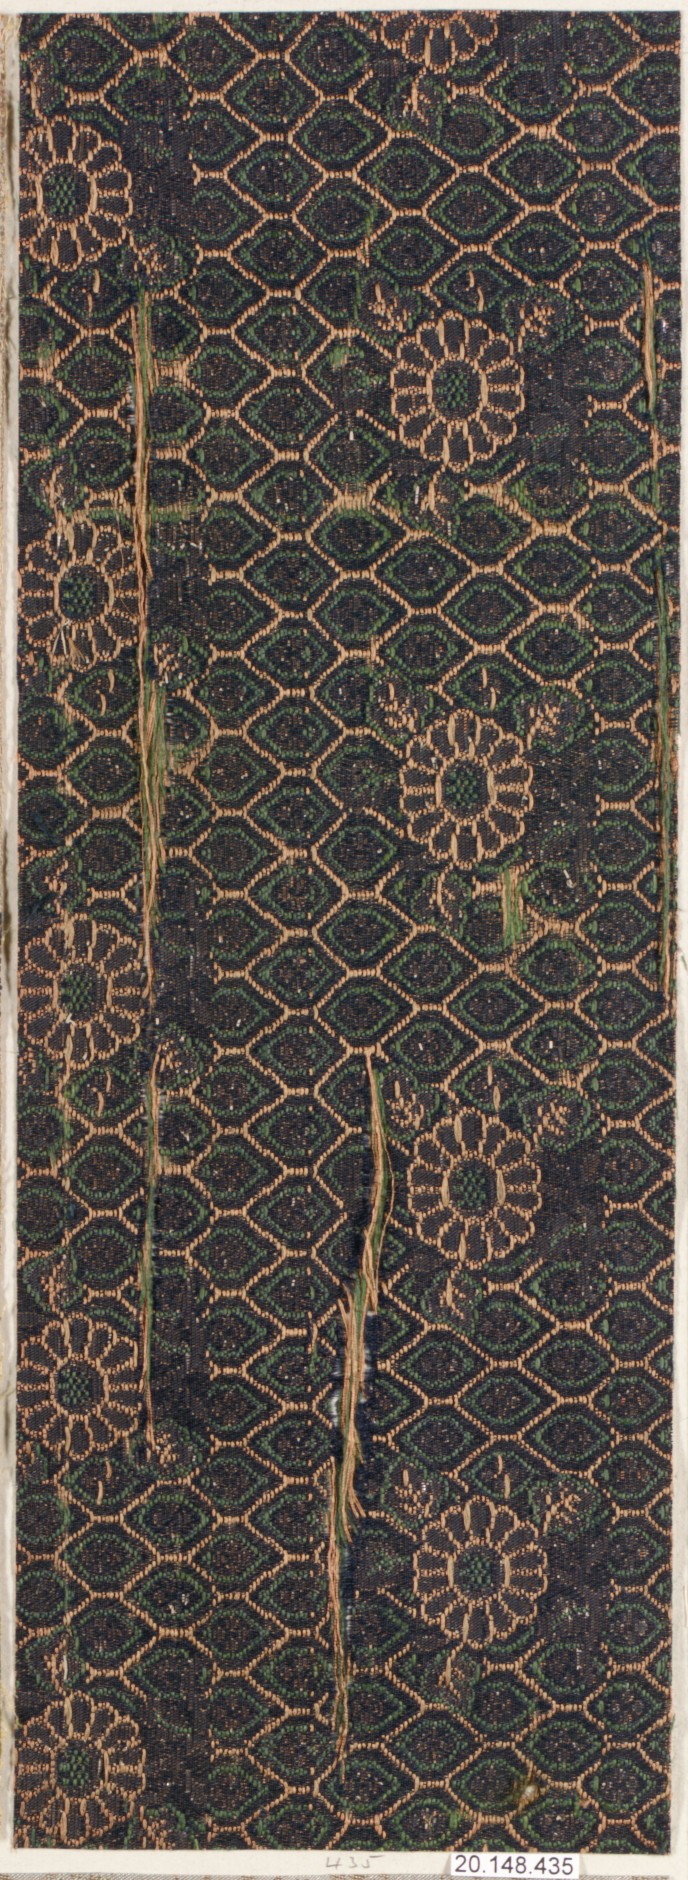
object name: piece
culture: japanese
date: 1701-1800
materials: silk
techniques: compound weave